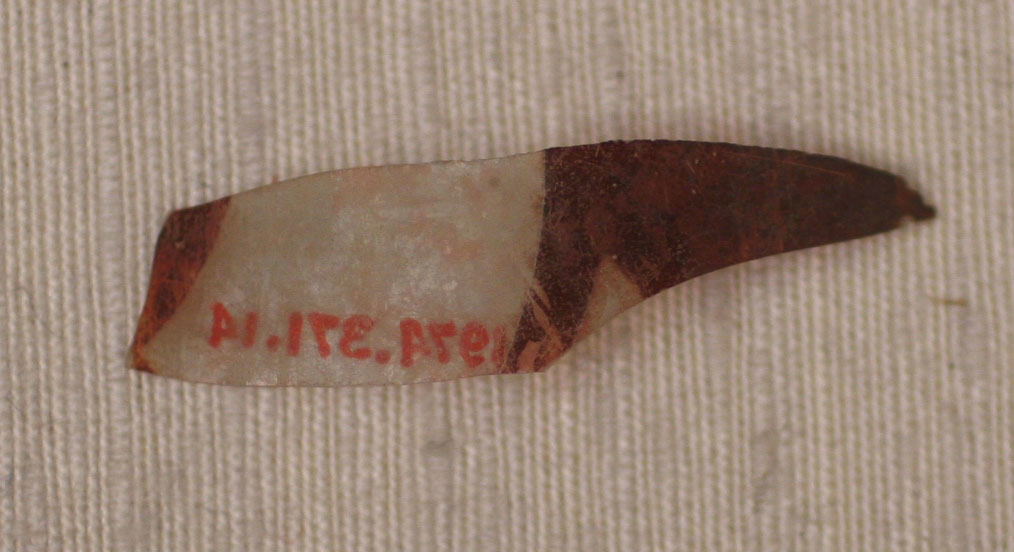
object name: fragment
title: Glass Fragment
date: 801-900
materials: glass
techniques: luster painting, stain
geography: egypt or iraq